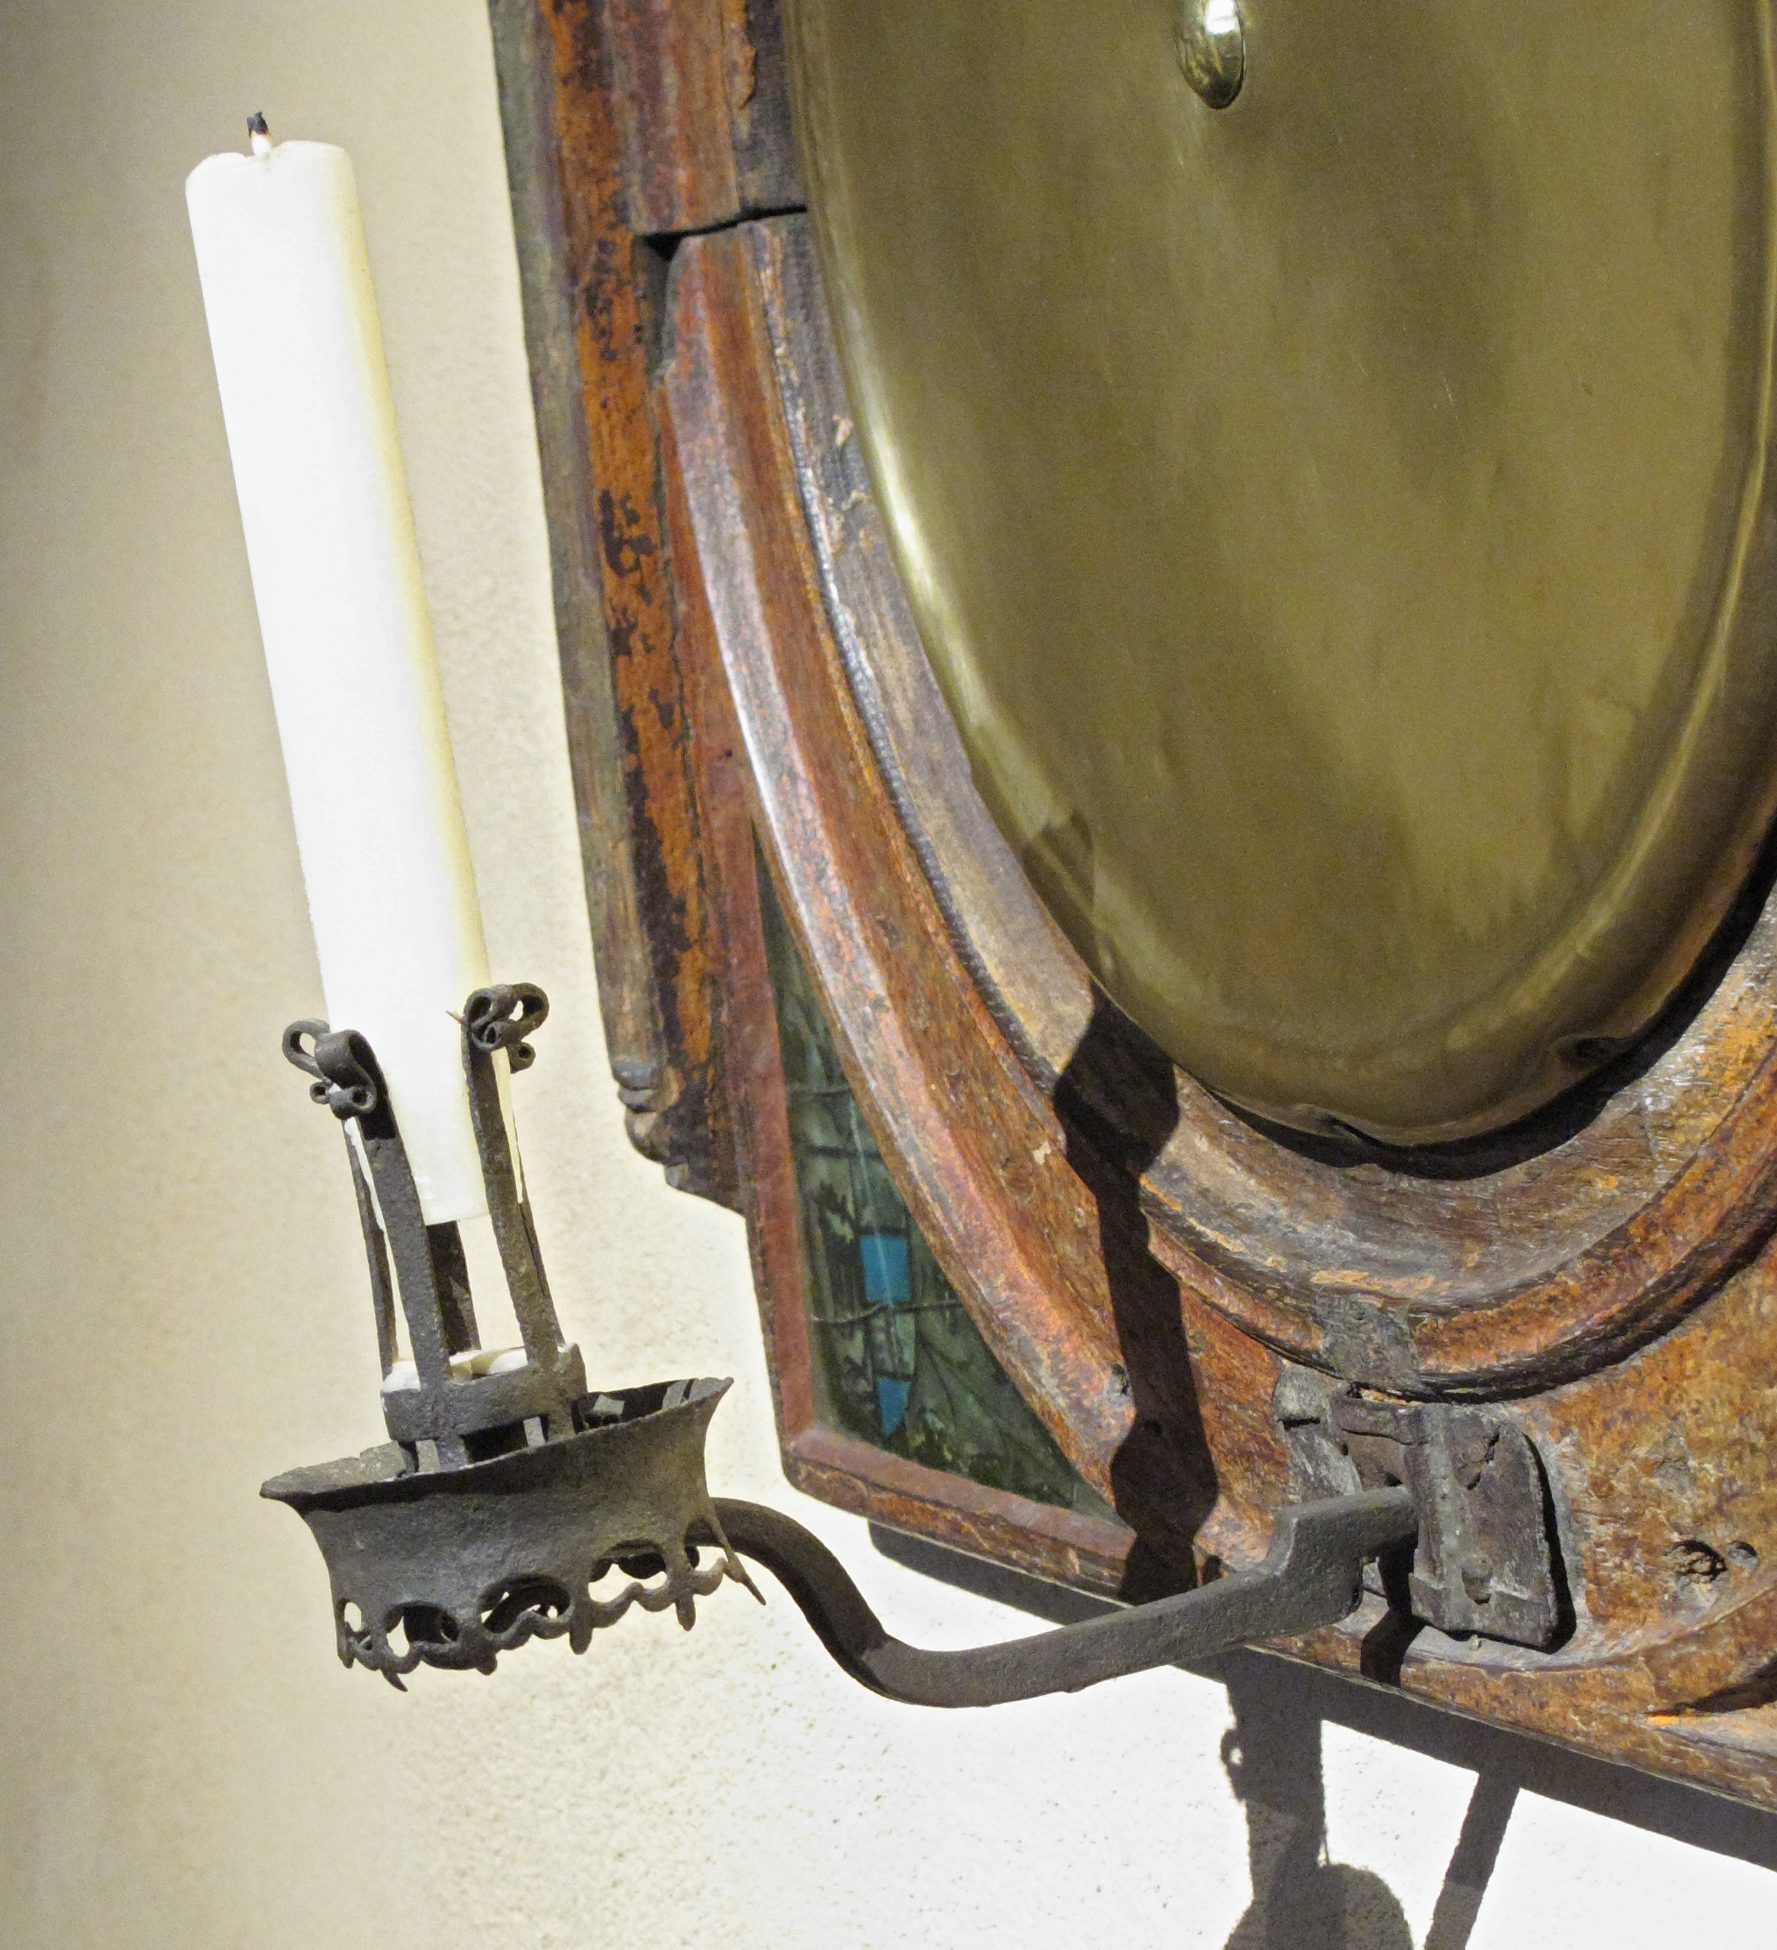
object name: candlestick bracket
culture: european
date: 1401-1600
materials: iron